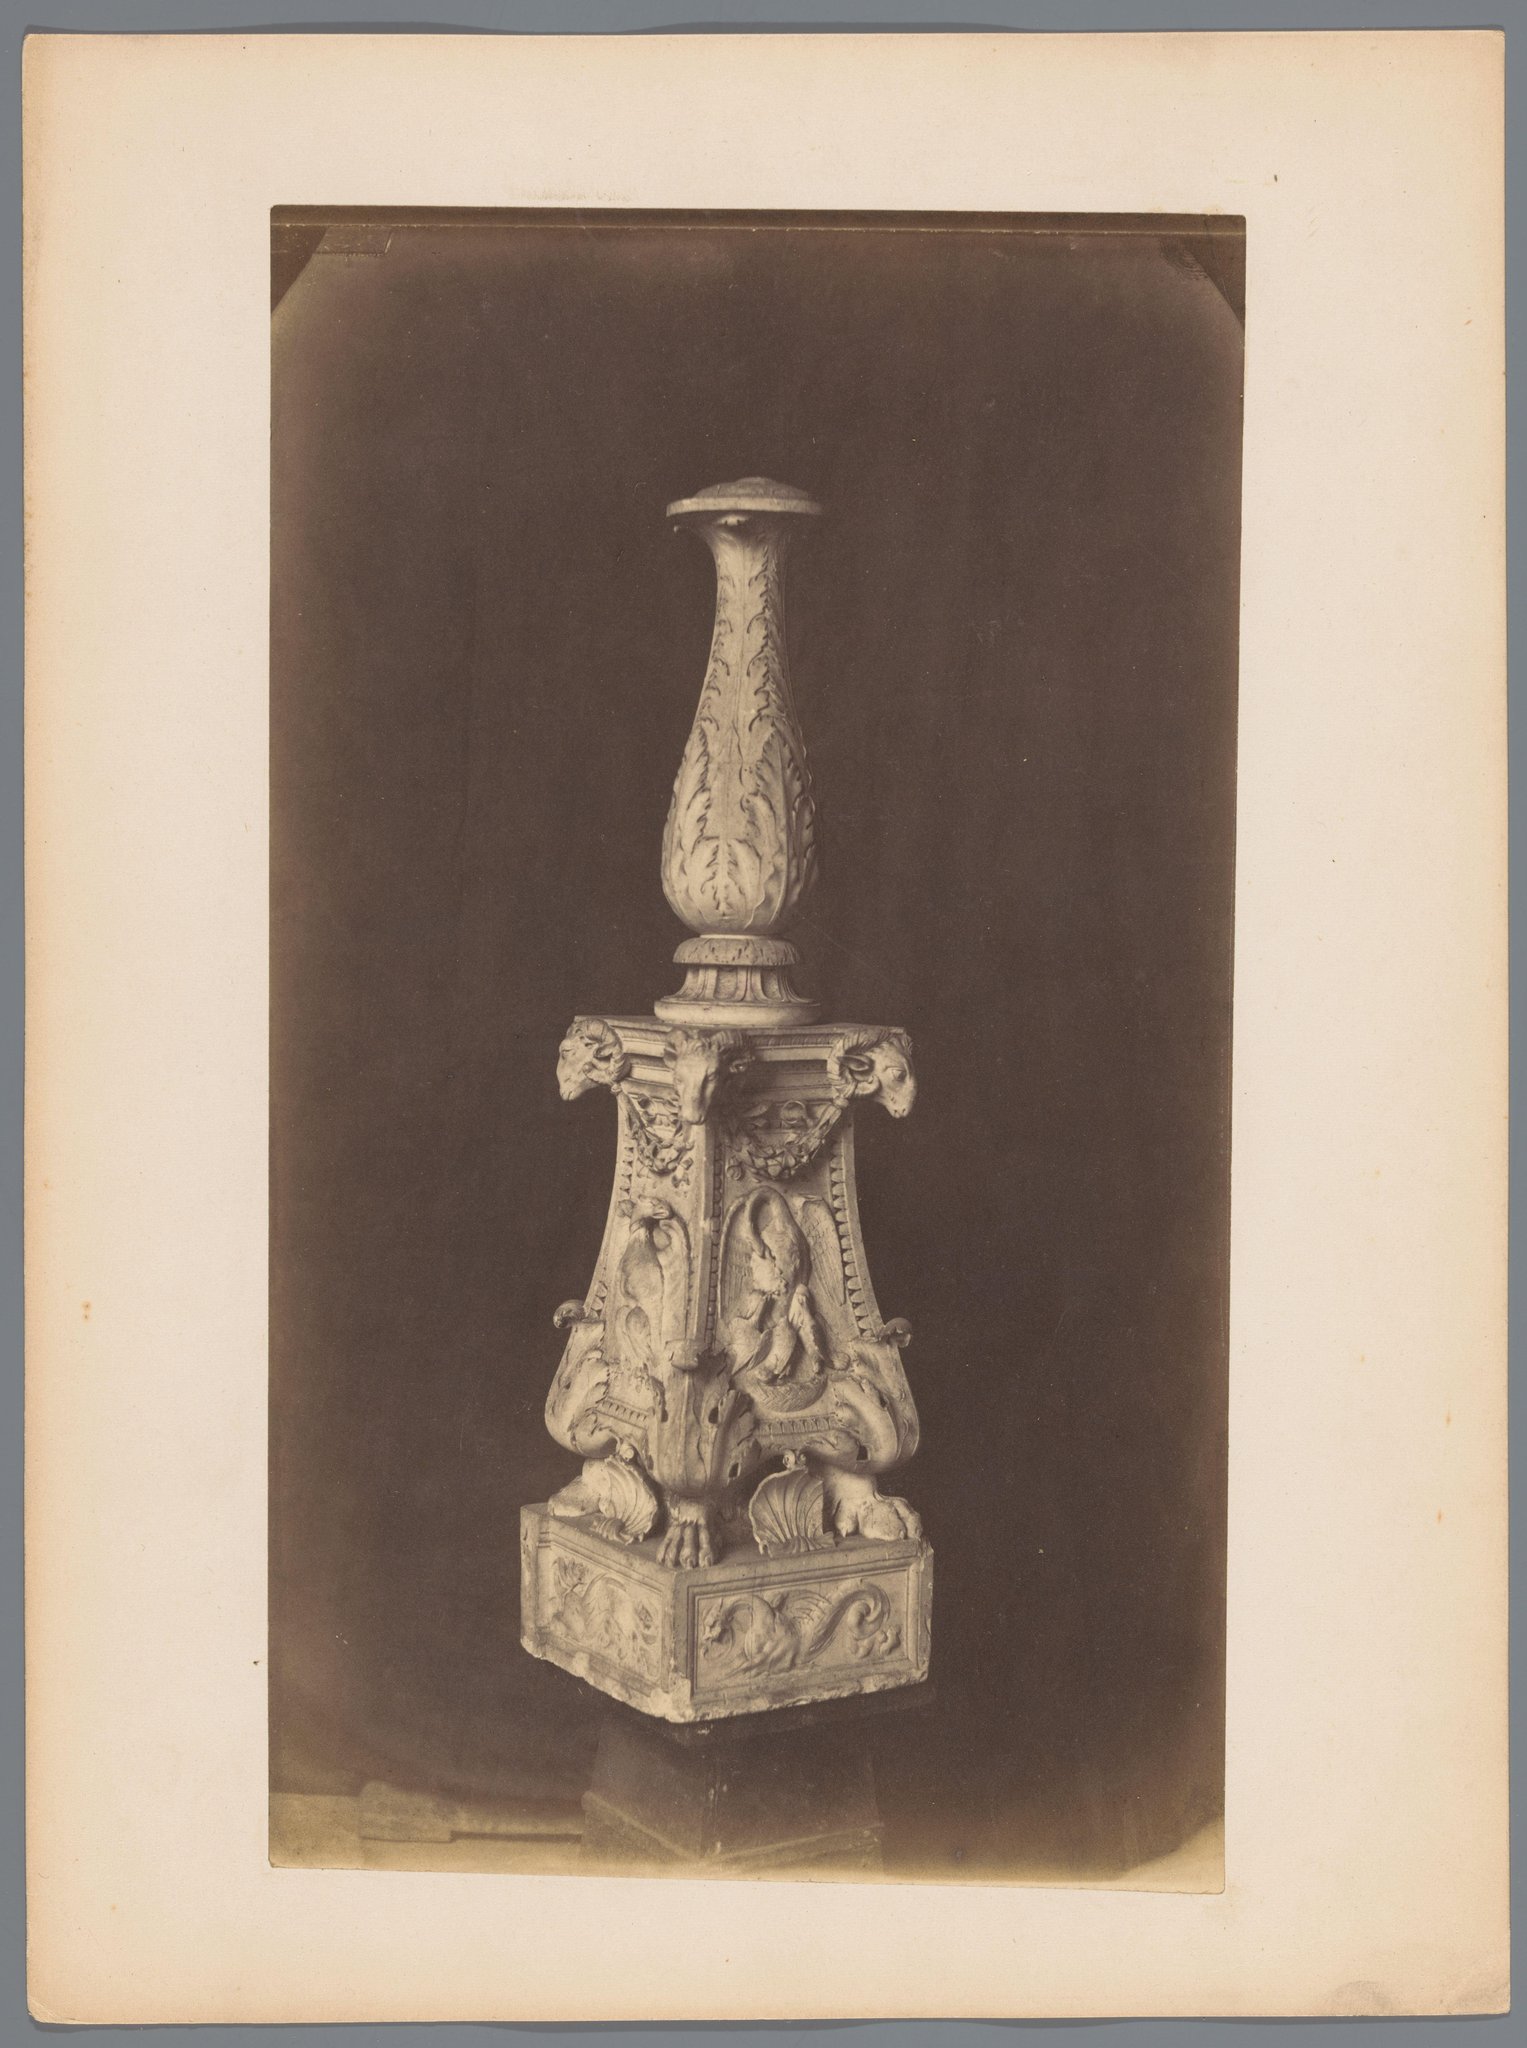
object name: photograph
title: Kandelaber met zeewezens, vogels en ramskoppen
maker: Anonymous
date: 1875-1900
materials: cardboard, photographic support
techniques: albumen print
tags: ram's head ~ ornament, ornamental birds, chandelier, candelabrum, monsters of the sea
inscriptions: collector's mark: Lugt 3937